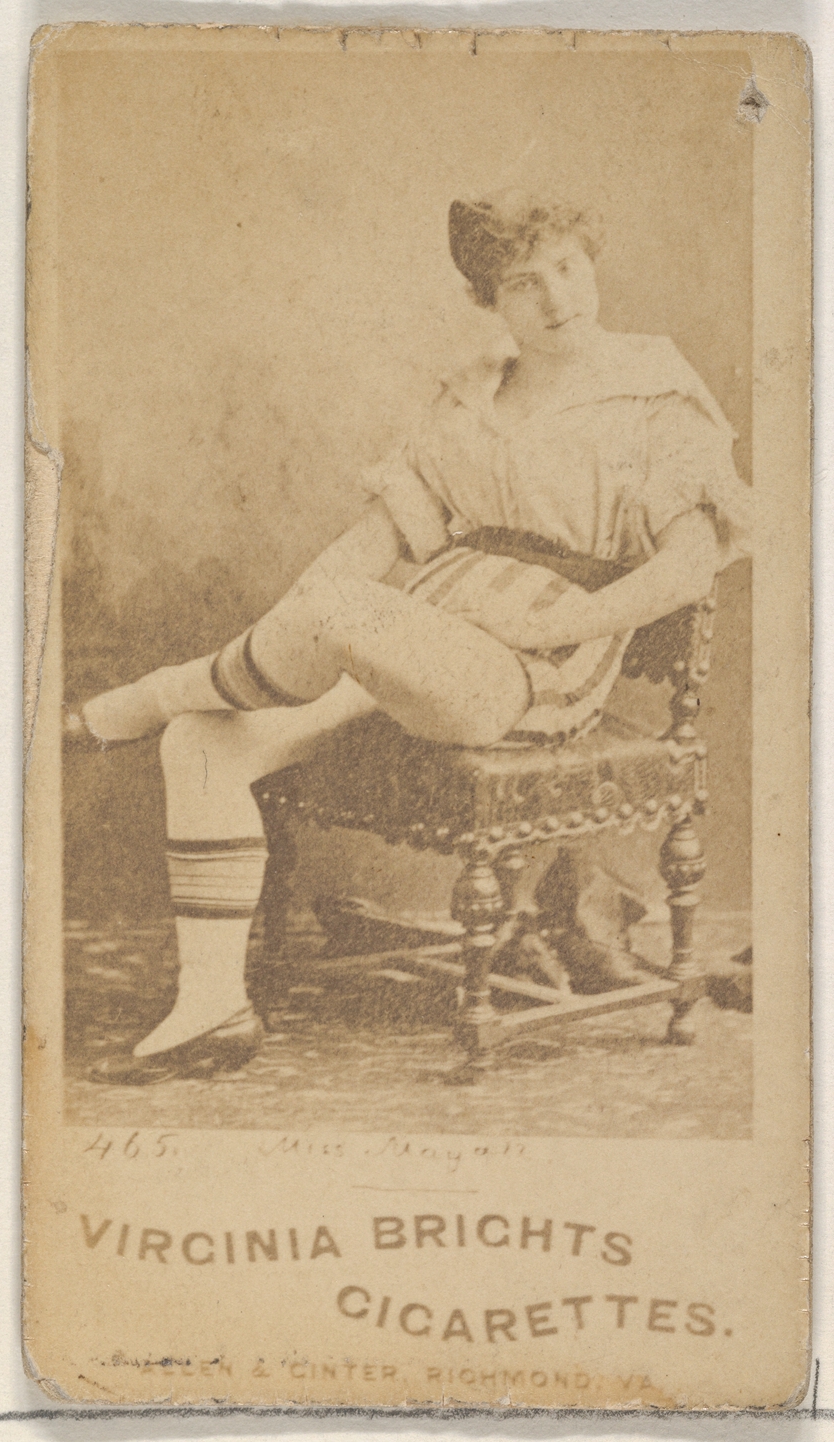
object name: photograph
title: Card 465, Miss Mayall, from the Actors and Actresses series (N45, Type 5) for Virginia Brights Cigarettes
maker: allen & ginter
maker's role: publisher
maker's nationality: american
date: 1888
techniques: albumen silver print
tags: portraits,women,actresses